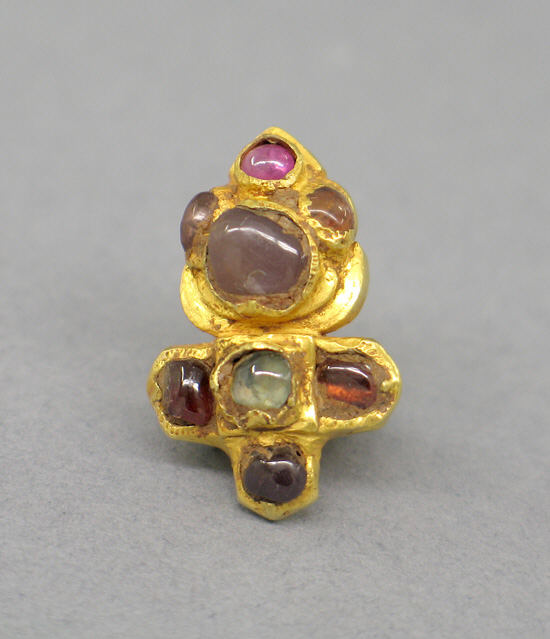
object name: ear clip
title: Ear Clip Inlaid with Eight Stones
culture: indonesian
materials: gold, stone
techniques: inlay